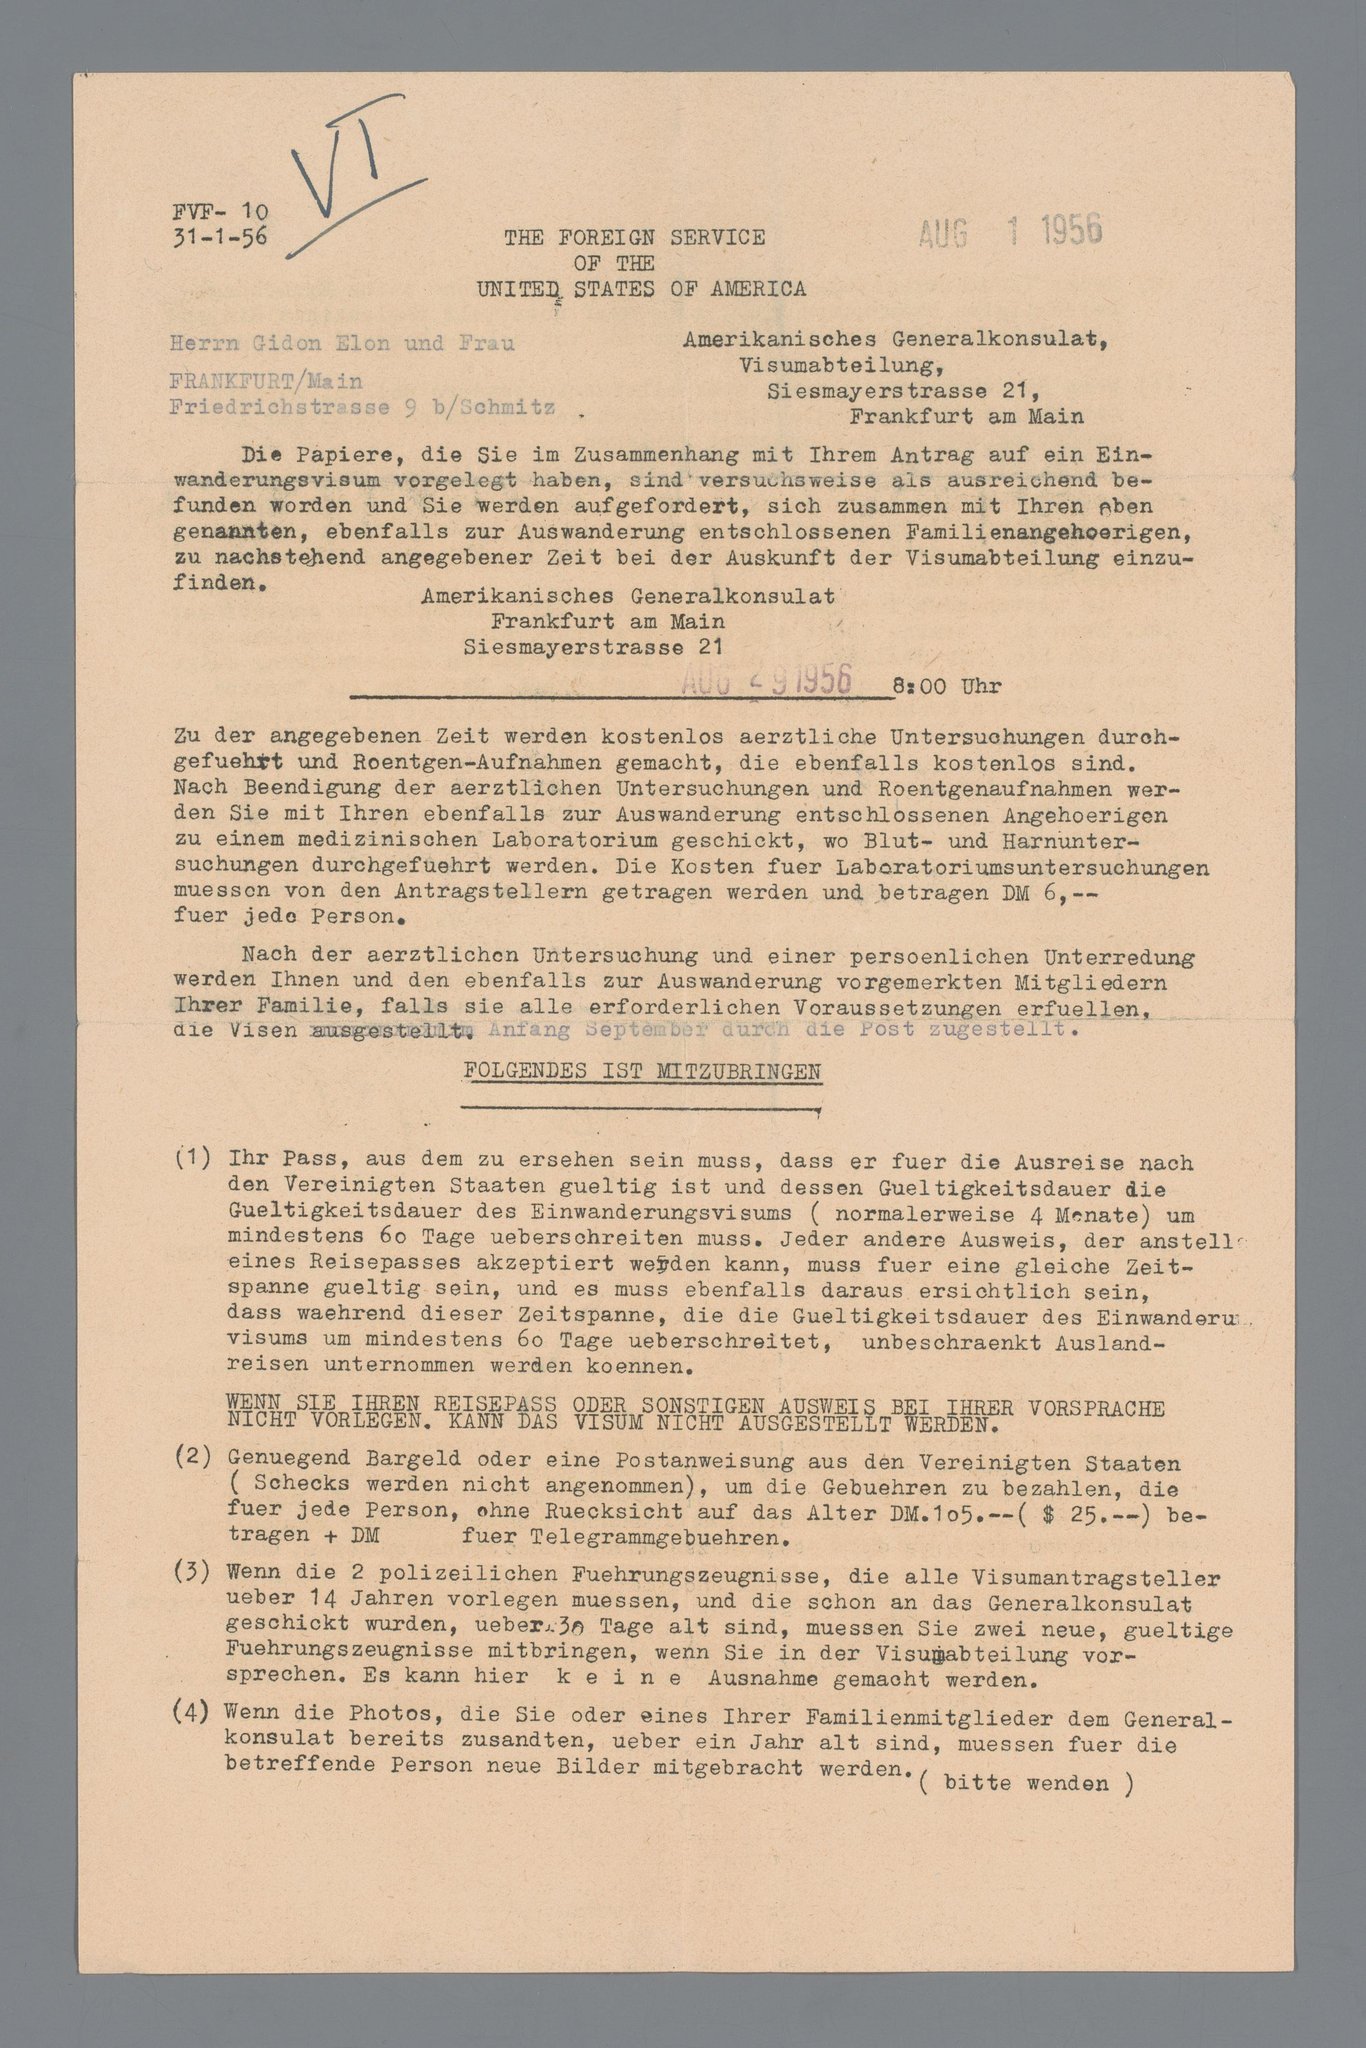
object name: correspondence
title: Correspondentie met betrekking tot het aanvragen van diverse visa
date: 1941-1942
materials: paper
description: Dit object is onderdeel van de nalatenschap van Isabel Elon-Wachenheimer (1928-2010). Tot haar overlijden behoorde het samen met de andere objecten uit de nalatenschap tot haar privédomein van Isabel Wachenheimer. In die particuliere context zijn deze objecten tezamen en individueel aandenkens - aan de jeugd, ouders en familie van Isabel Wachenheimer vóór en tijdens de Shoah en aan haar leven na de Tweede Wereldoorlog. Isabel Wachenheimer, die van juni 1943 tot mei 1945 gevangen zat in Kamp Westerbork, Theresienstadt, Auschwitz, Lenzing a/d Oberdonau (een buitenkamp van Mauthausen), overleefde de Shoah. Haar ouders – Eugène Wachenheimer en Else Wachenheimer-Moos - werden op 14 oktober 1944 in Auschwitz-Birkenau vermoord.